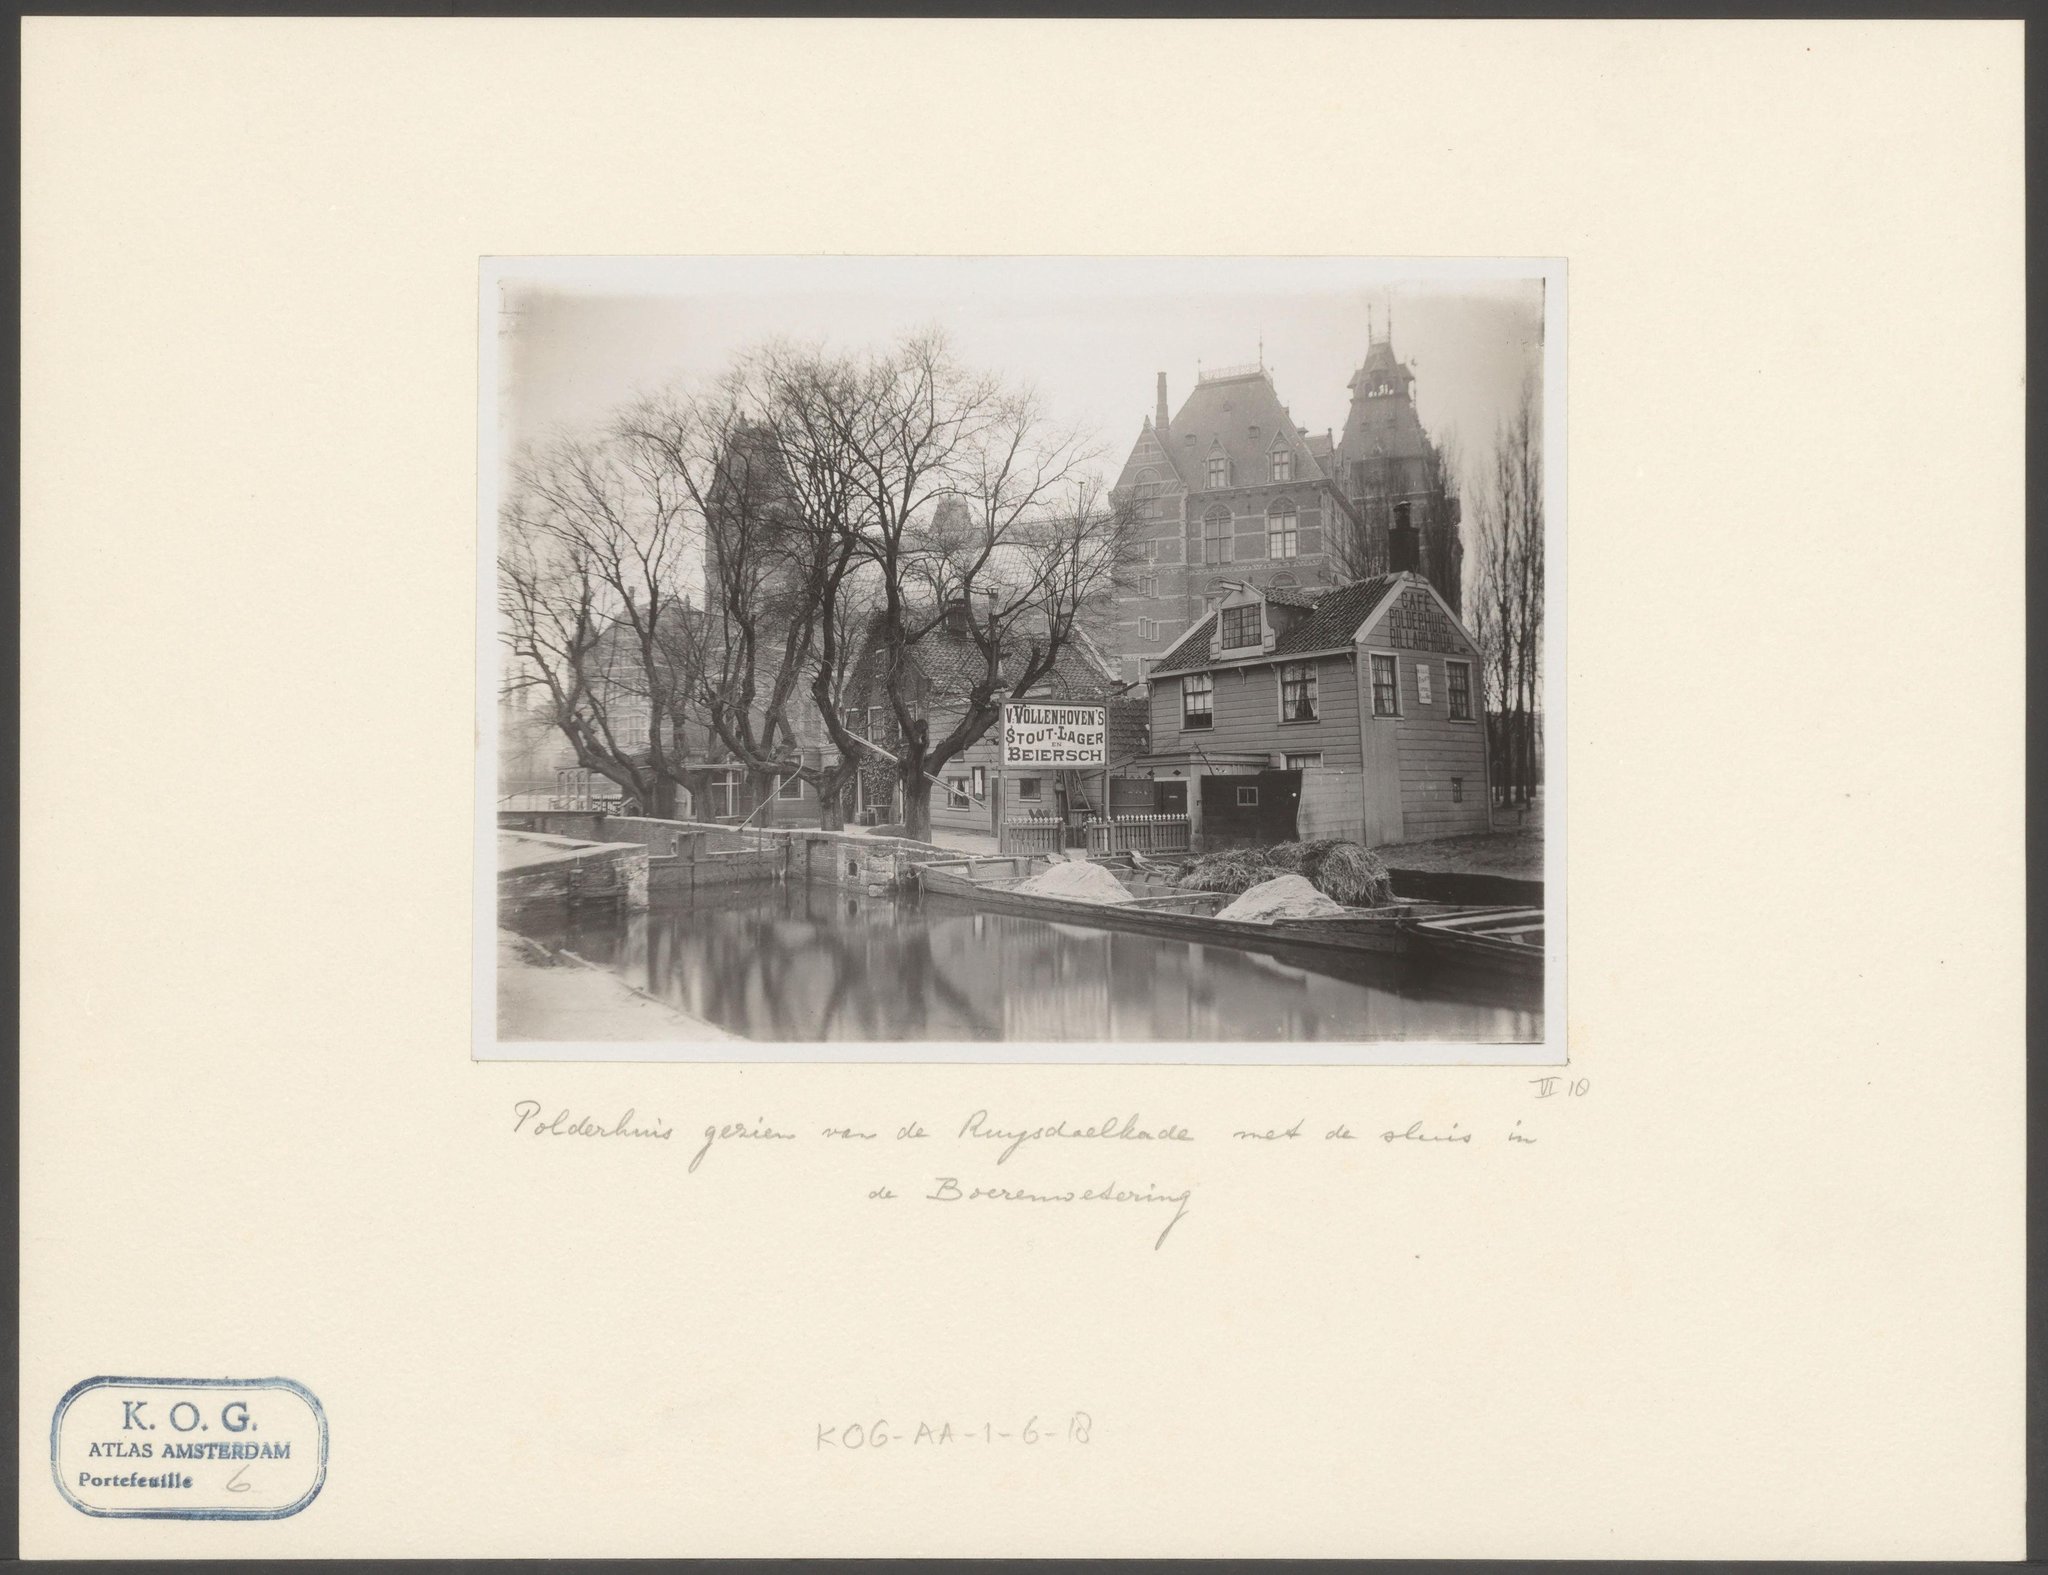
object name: photograph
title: Gezicht op het Polderhuis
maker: Anonymous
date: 1875-1925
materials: paper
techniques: gelatin silver print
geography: amsterdam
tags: city-view in general; 'veduta', canal, inn, coffee-house, public house, etc., rolling bridge (dutch: 'overtoom')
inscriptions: collector's mark: ‘6’ Lugt 1641b, inscription: ‘Polderhuis gezien van de Ruysdaelkade met de sluis in / de Boerenwetering’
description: Onderwerpsrubriek binnen de Atlas Amsterdam: Buitensingel of wel: Gezichten langs en op de Stadsvest van Raampoort tot Zeeburgerdijk.